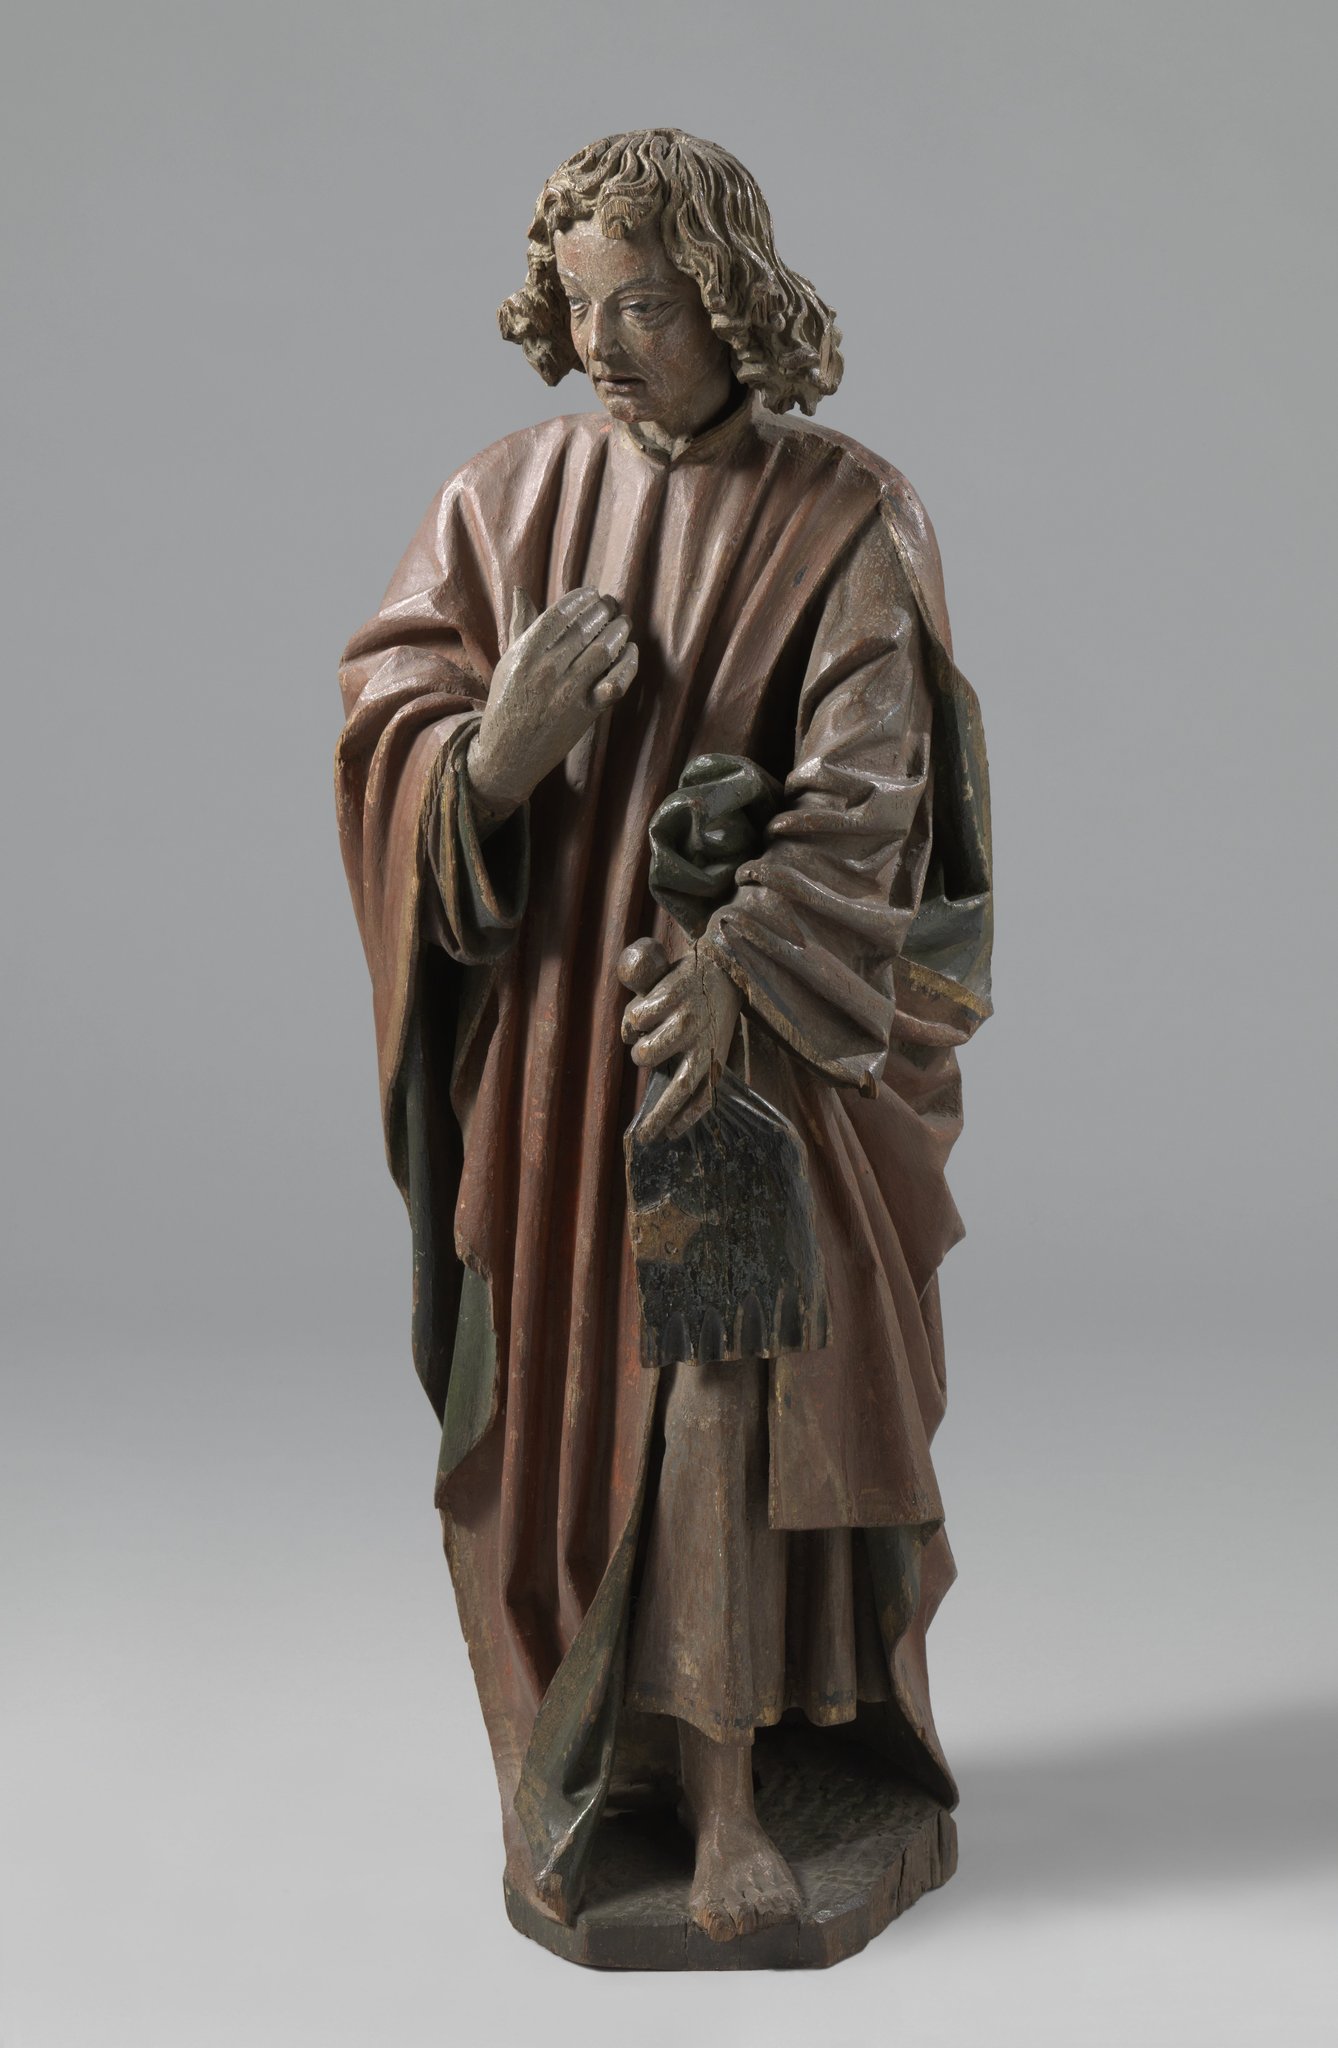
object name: sculpture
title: St John the Evangelist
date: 1540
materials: wood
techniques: polychromy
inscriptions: inscription, on the reverse, in white paint: ‘KU 1210’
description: Hij staat op een grondje met het gebogen linkerbeen naar voren, draagt in de linkerhand een boek aan de buidel en houdt de vingers van de rechterhand tegen de borst. Zijn gelaat vertoont diepe groeven rondom ogen en mond, het krullende haar staat van de slapen af. Over een tuniek met breed uitlopende mouwen hangt de ruime mantel, die onder de linkerarm is opgenomen. De mantel met opstaand kraagje is aan de rechter zijkant open. Beide voeten komen onder de mantel te voorschijn.